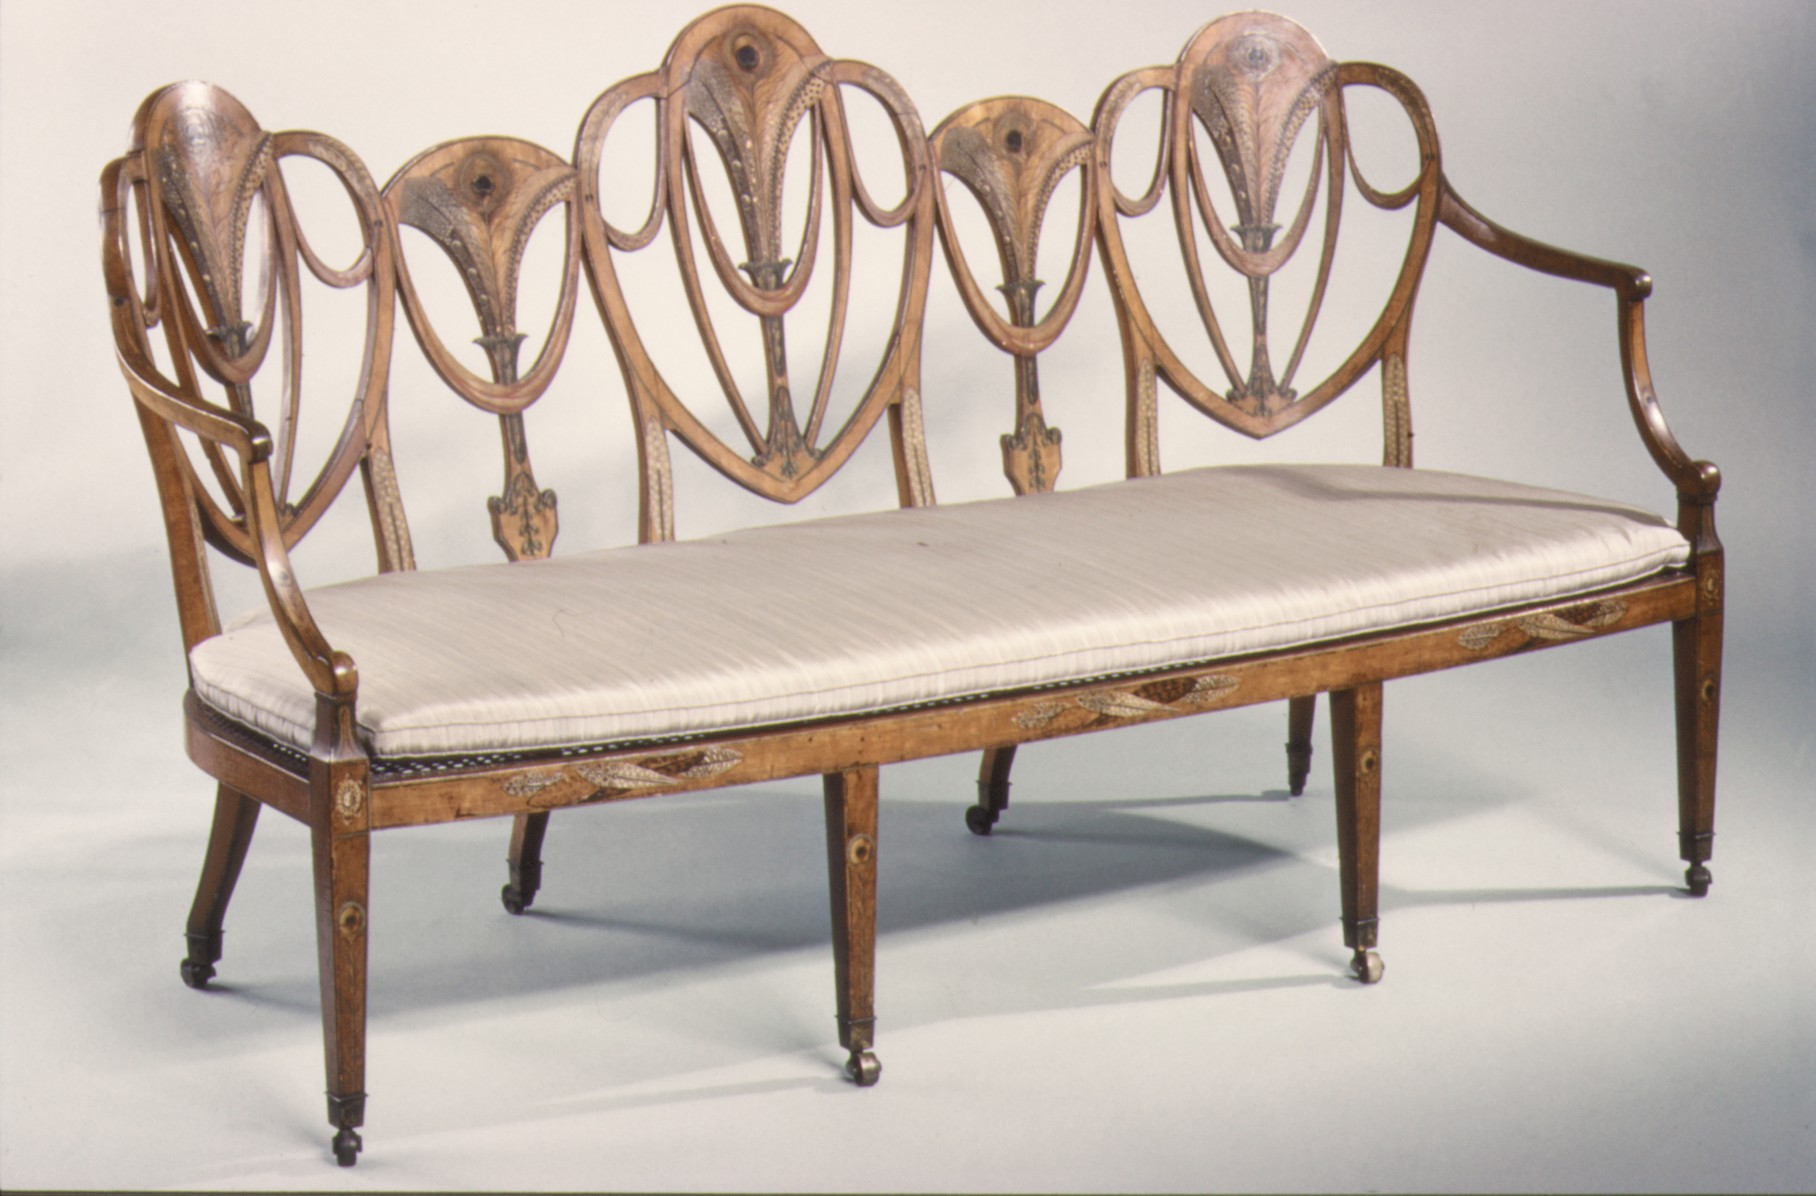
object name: chair settee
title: Triple-back chair settee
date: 1785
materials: wood